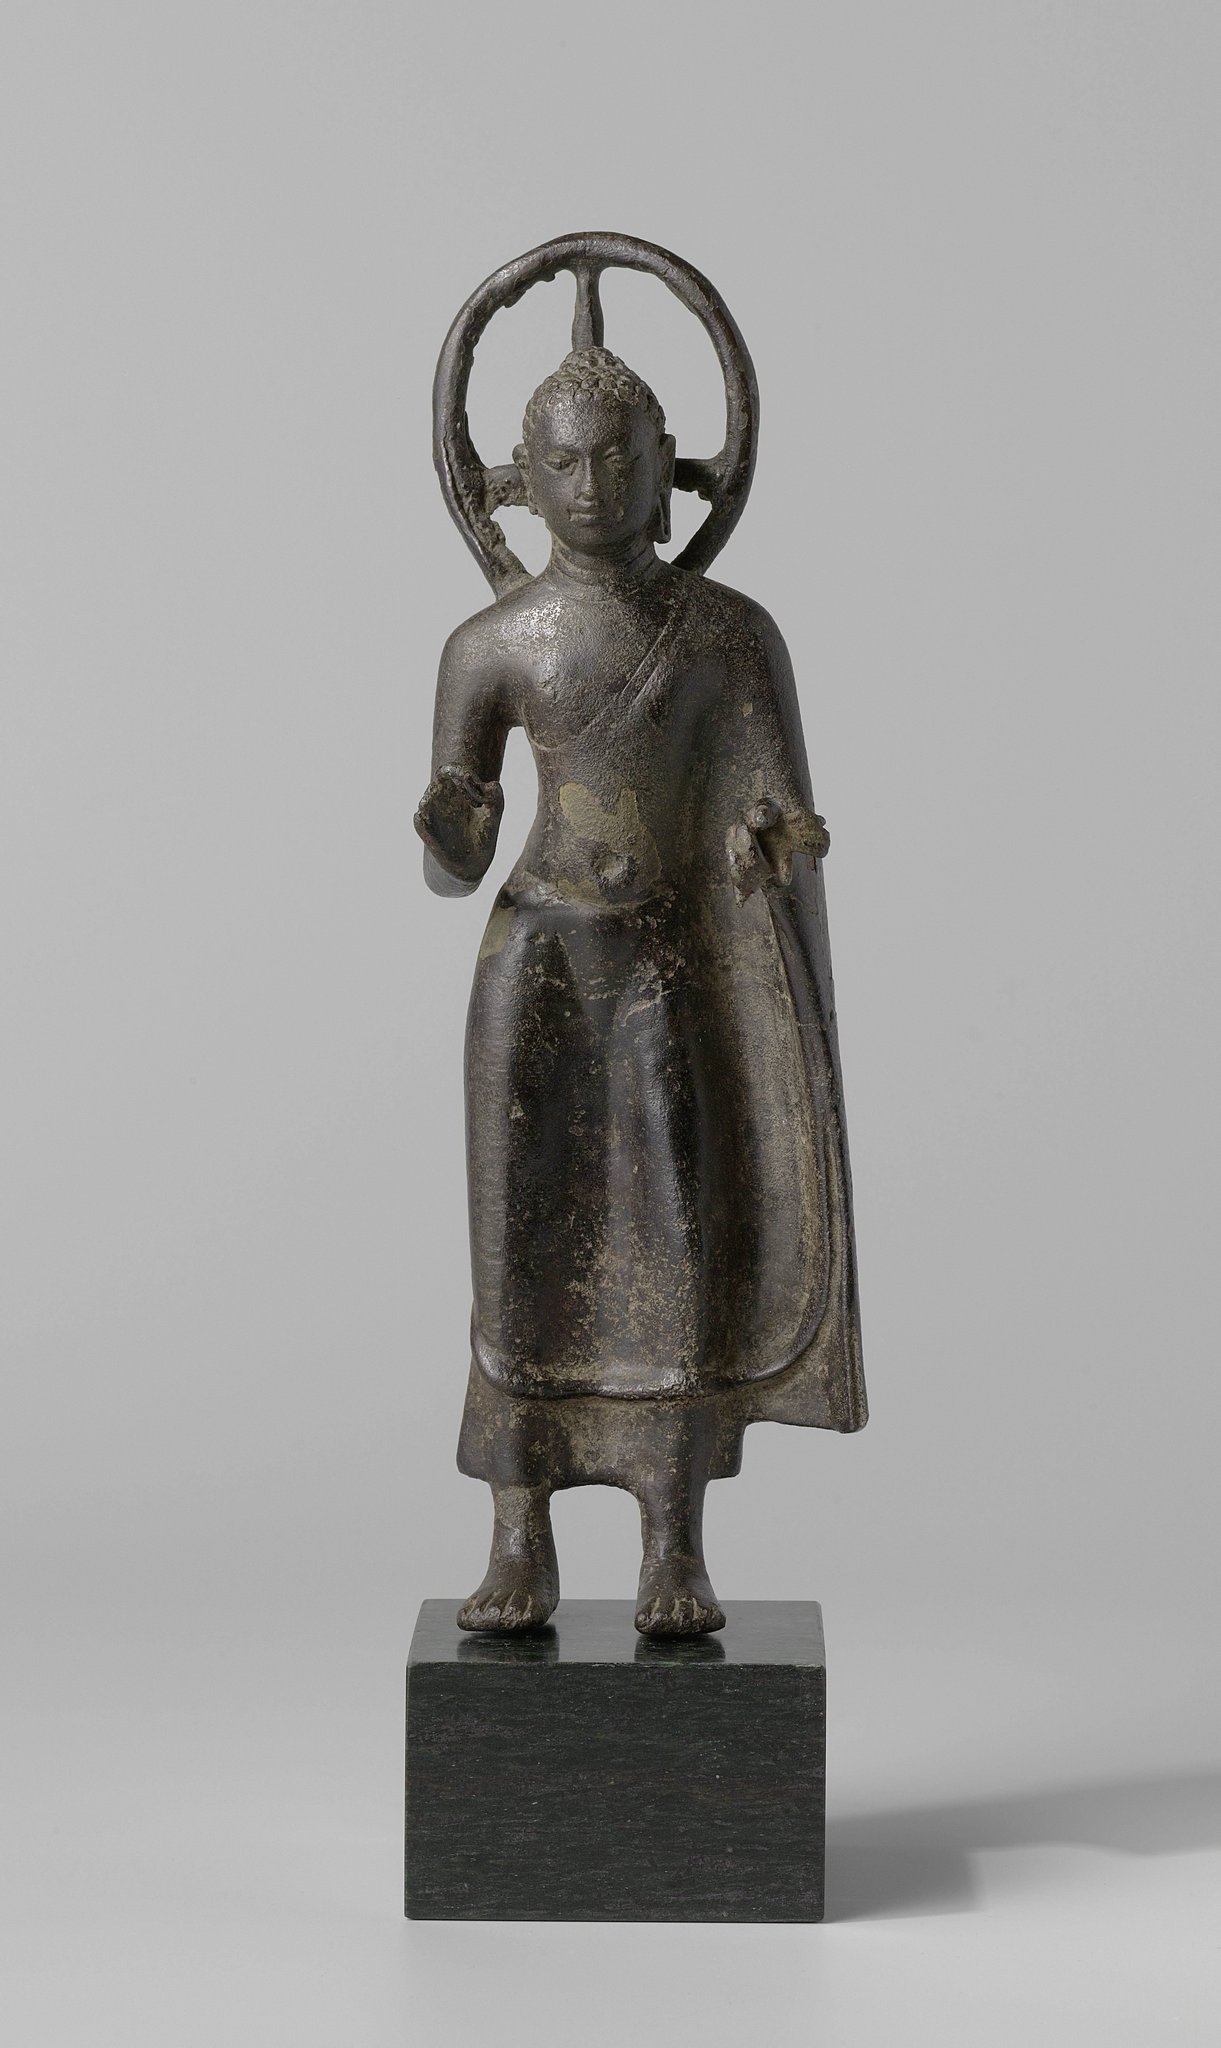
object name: sculpture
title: Standing Buddha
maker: Anonymous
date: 600-800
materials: bronze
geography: south sumatra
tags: buddha, founder of buddhism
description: This kind of Buddha figurine is based on Indian models and was widely distributed in Southeast Asia, from Thailand to Indonesia. With his right hand, the Buddha is making the vitarka mudra, the gesture of teaching. The halo behind his head may be a later addition.